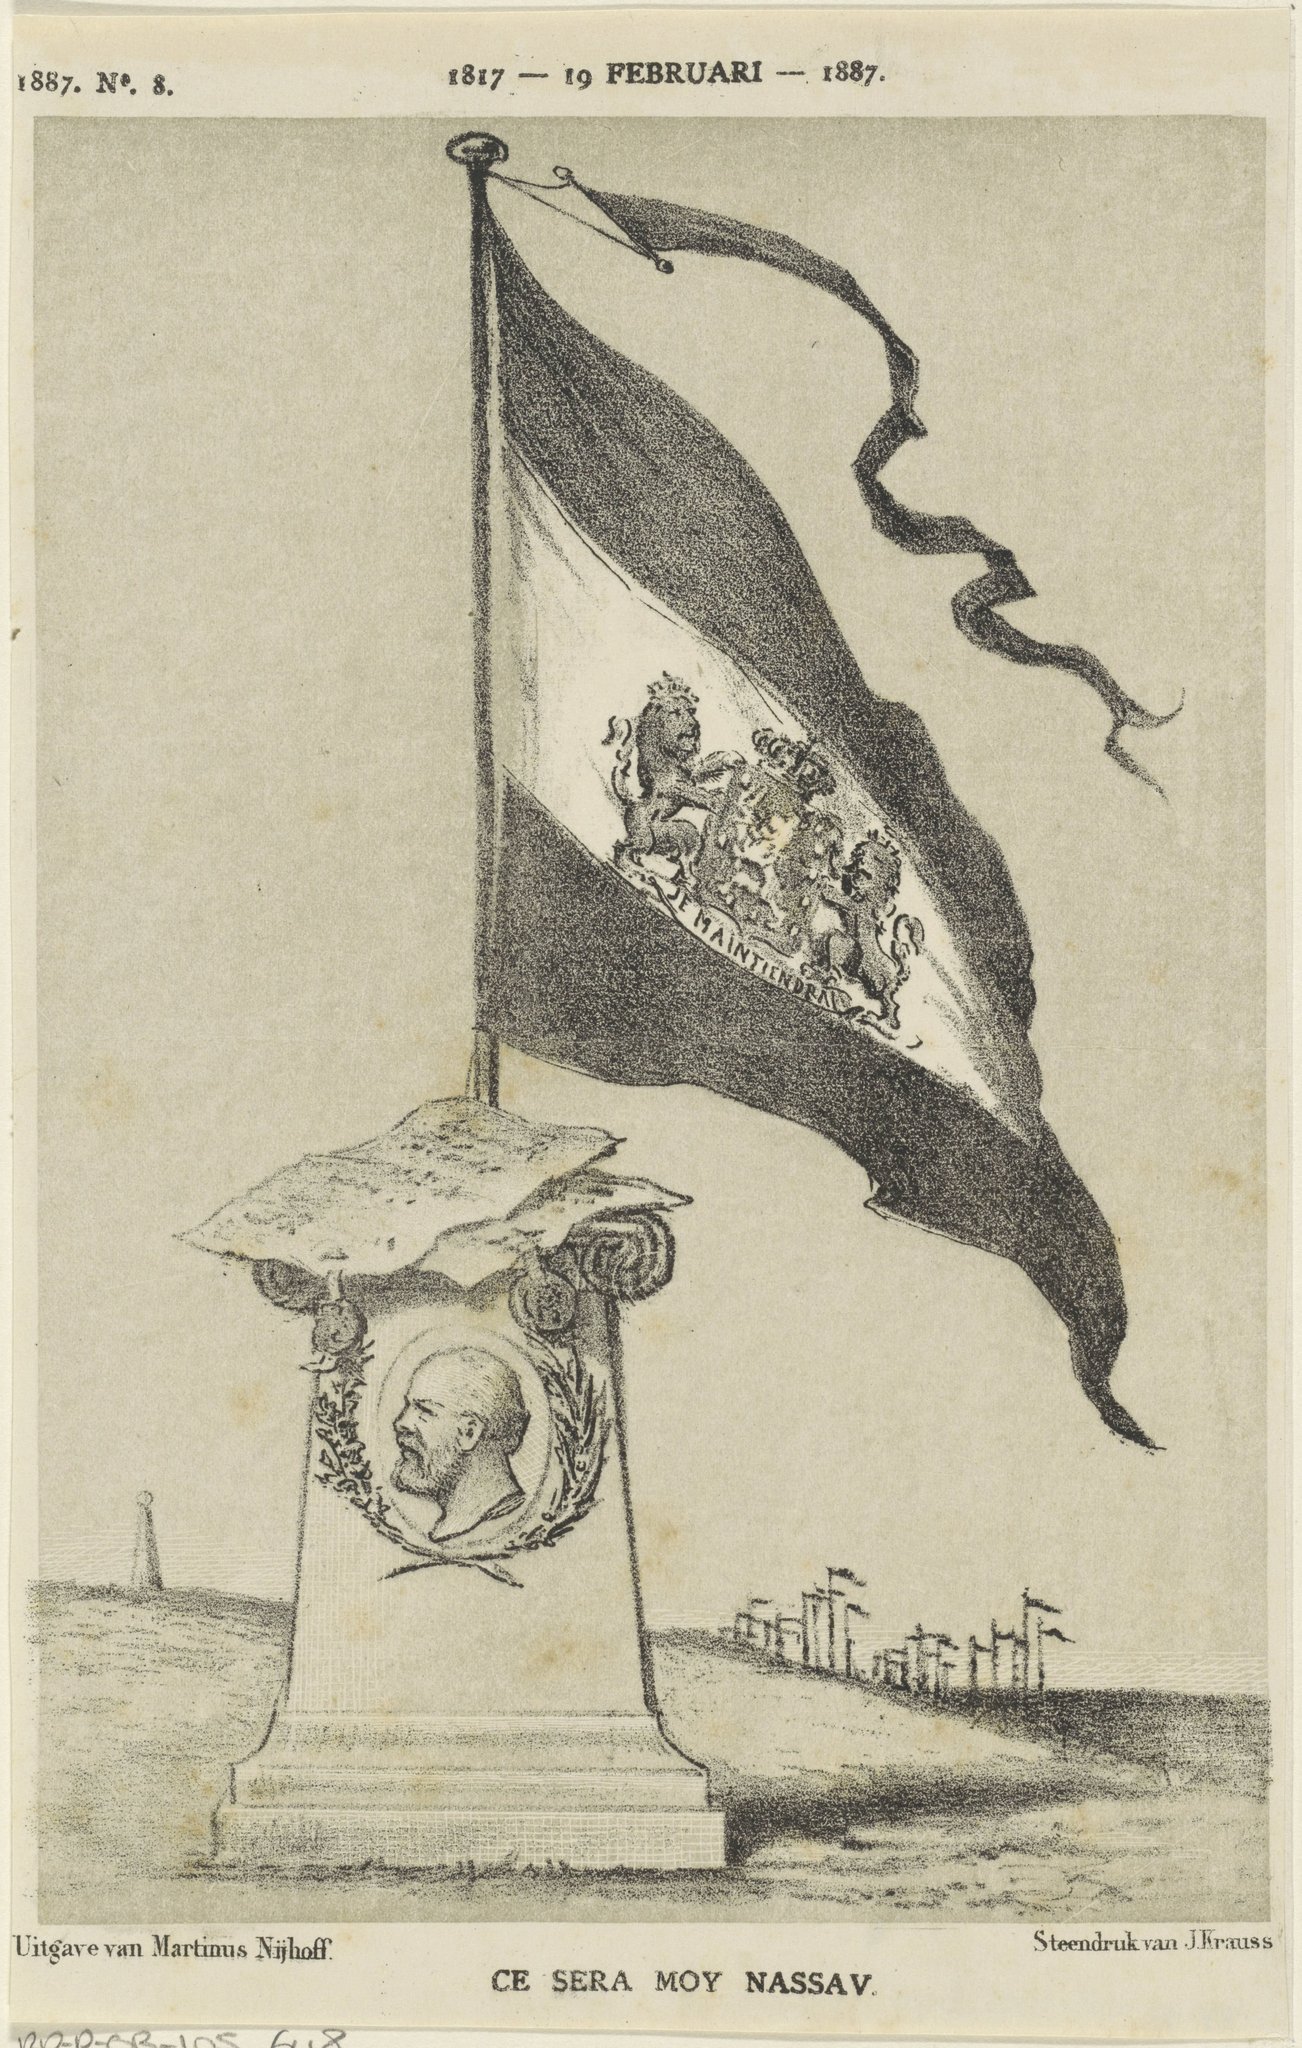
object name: print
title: Monument voor Willem III, koning der Nederlanden, ter gelegenheid van de viering van zijn zeventigste verjaardag op 19 februari 1887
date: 1887-1889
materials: paper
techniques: lithograph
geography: netherlands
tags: brussels, willem iii (koning der nederlanden)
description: Monument voor Willem III ter gelegenheid van de viering van zijn zeventigste verjaardag op 19 februari 1887. In de bovenmarge '1817-19 FEBRUARI-1887' en in de ondermarge een regel Franse tekst. Linksboven '1887. No. 8.'.